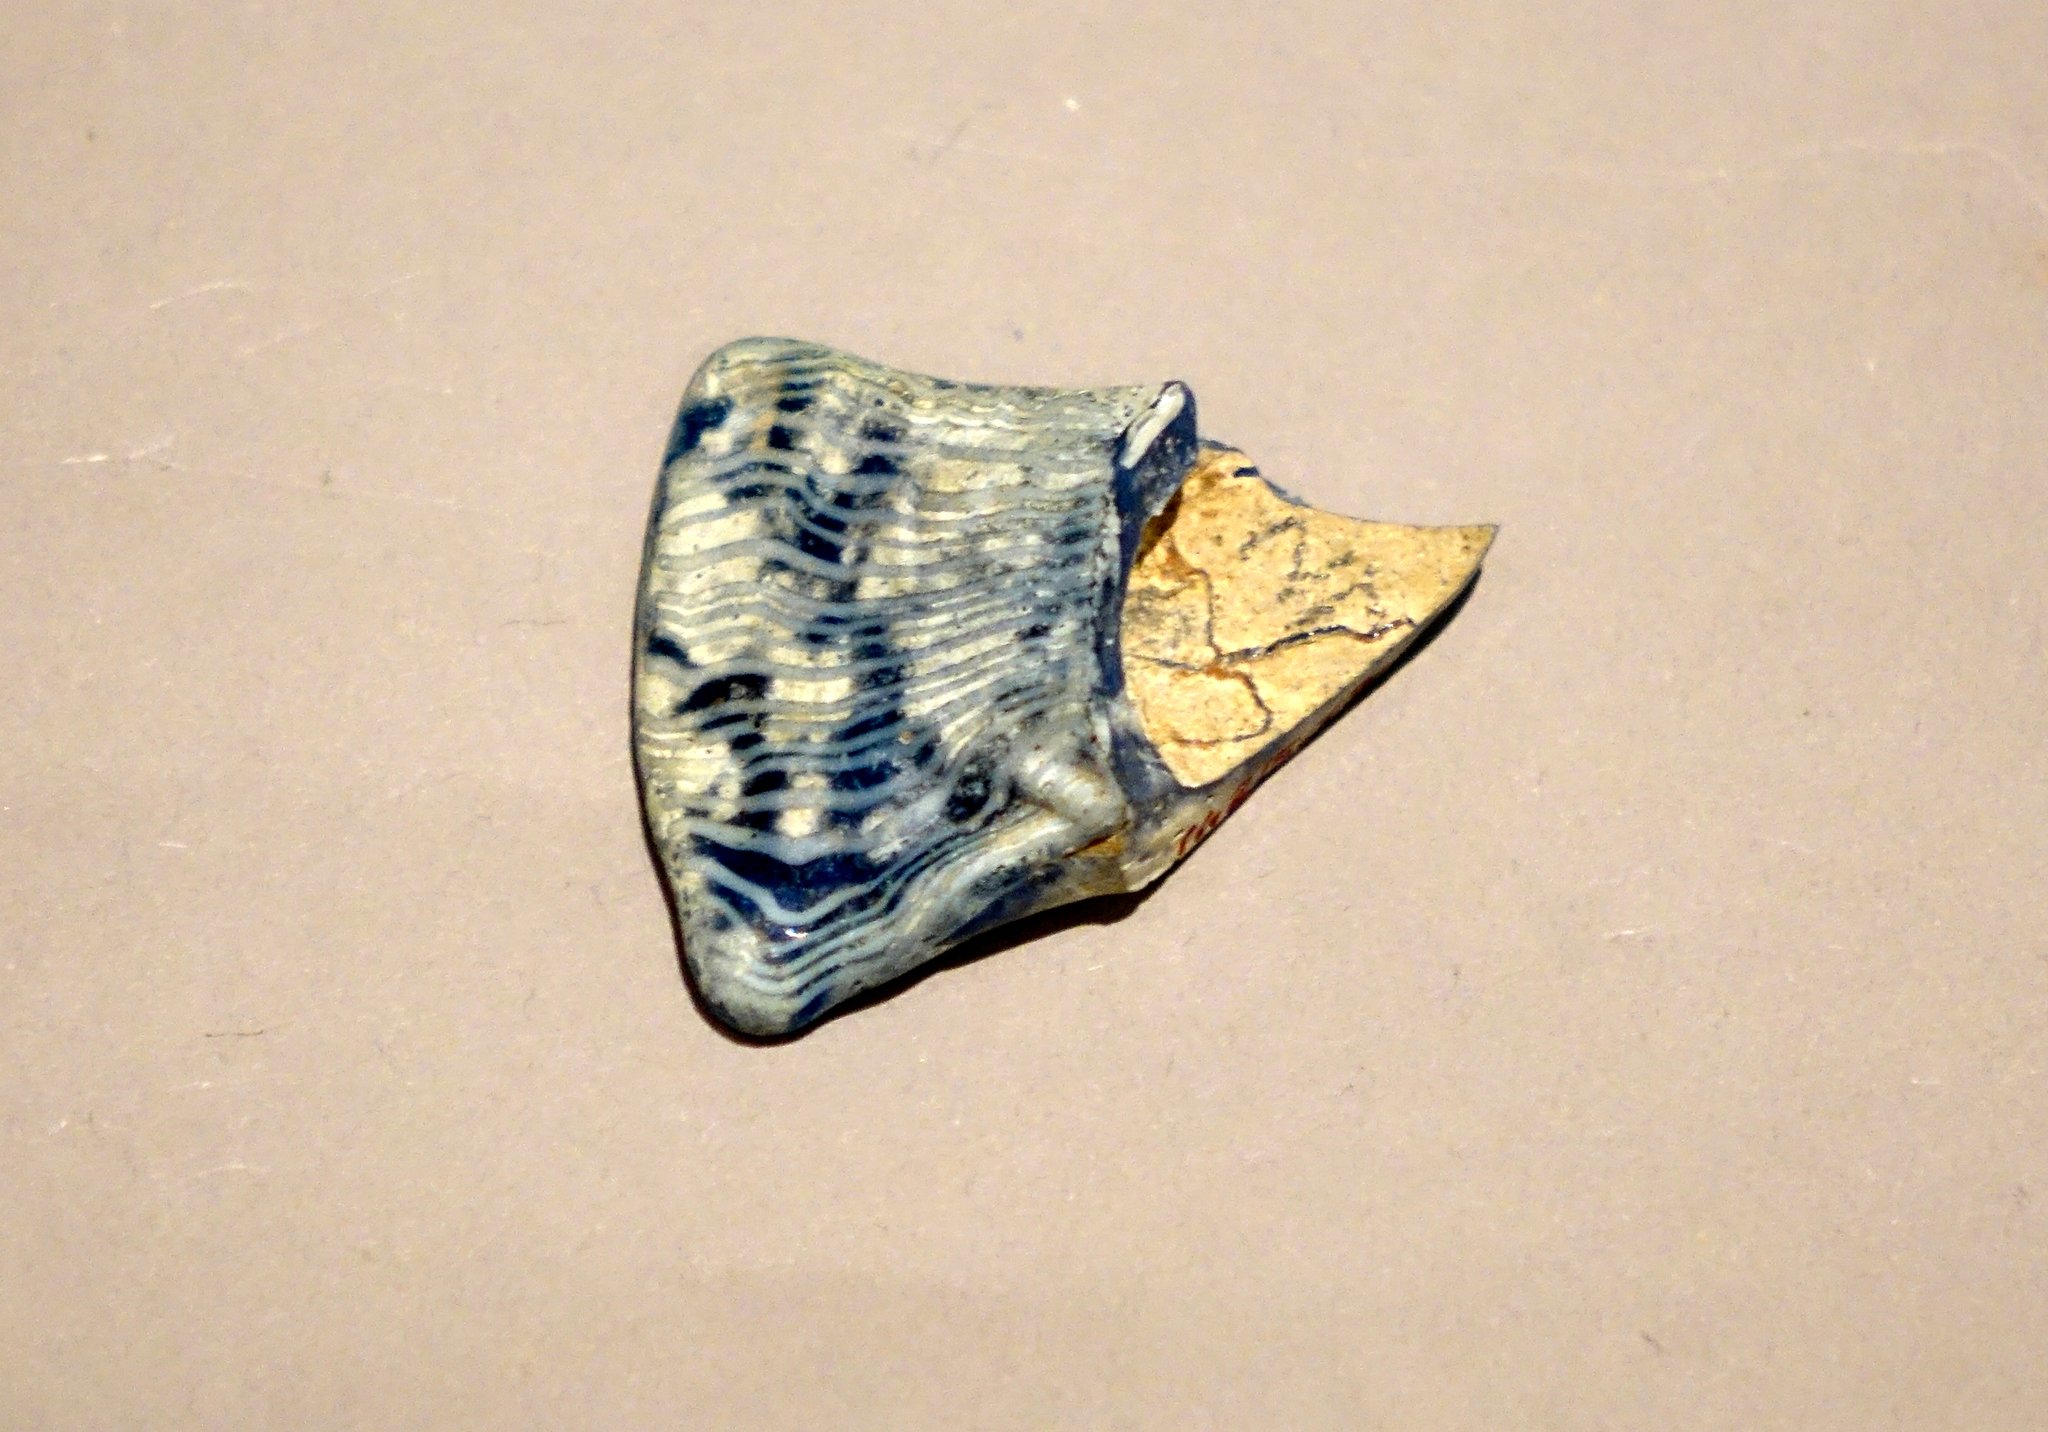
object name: bottle fragment, fish tail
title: Fragment of Bottle in Shape of Fish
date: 1390-1352 BCE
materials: glass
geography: egypt